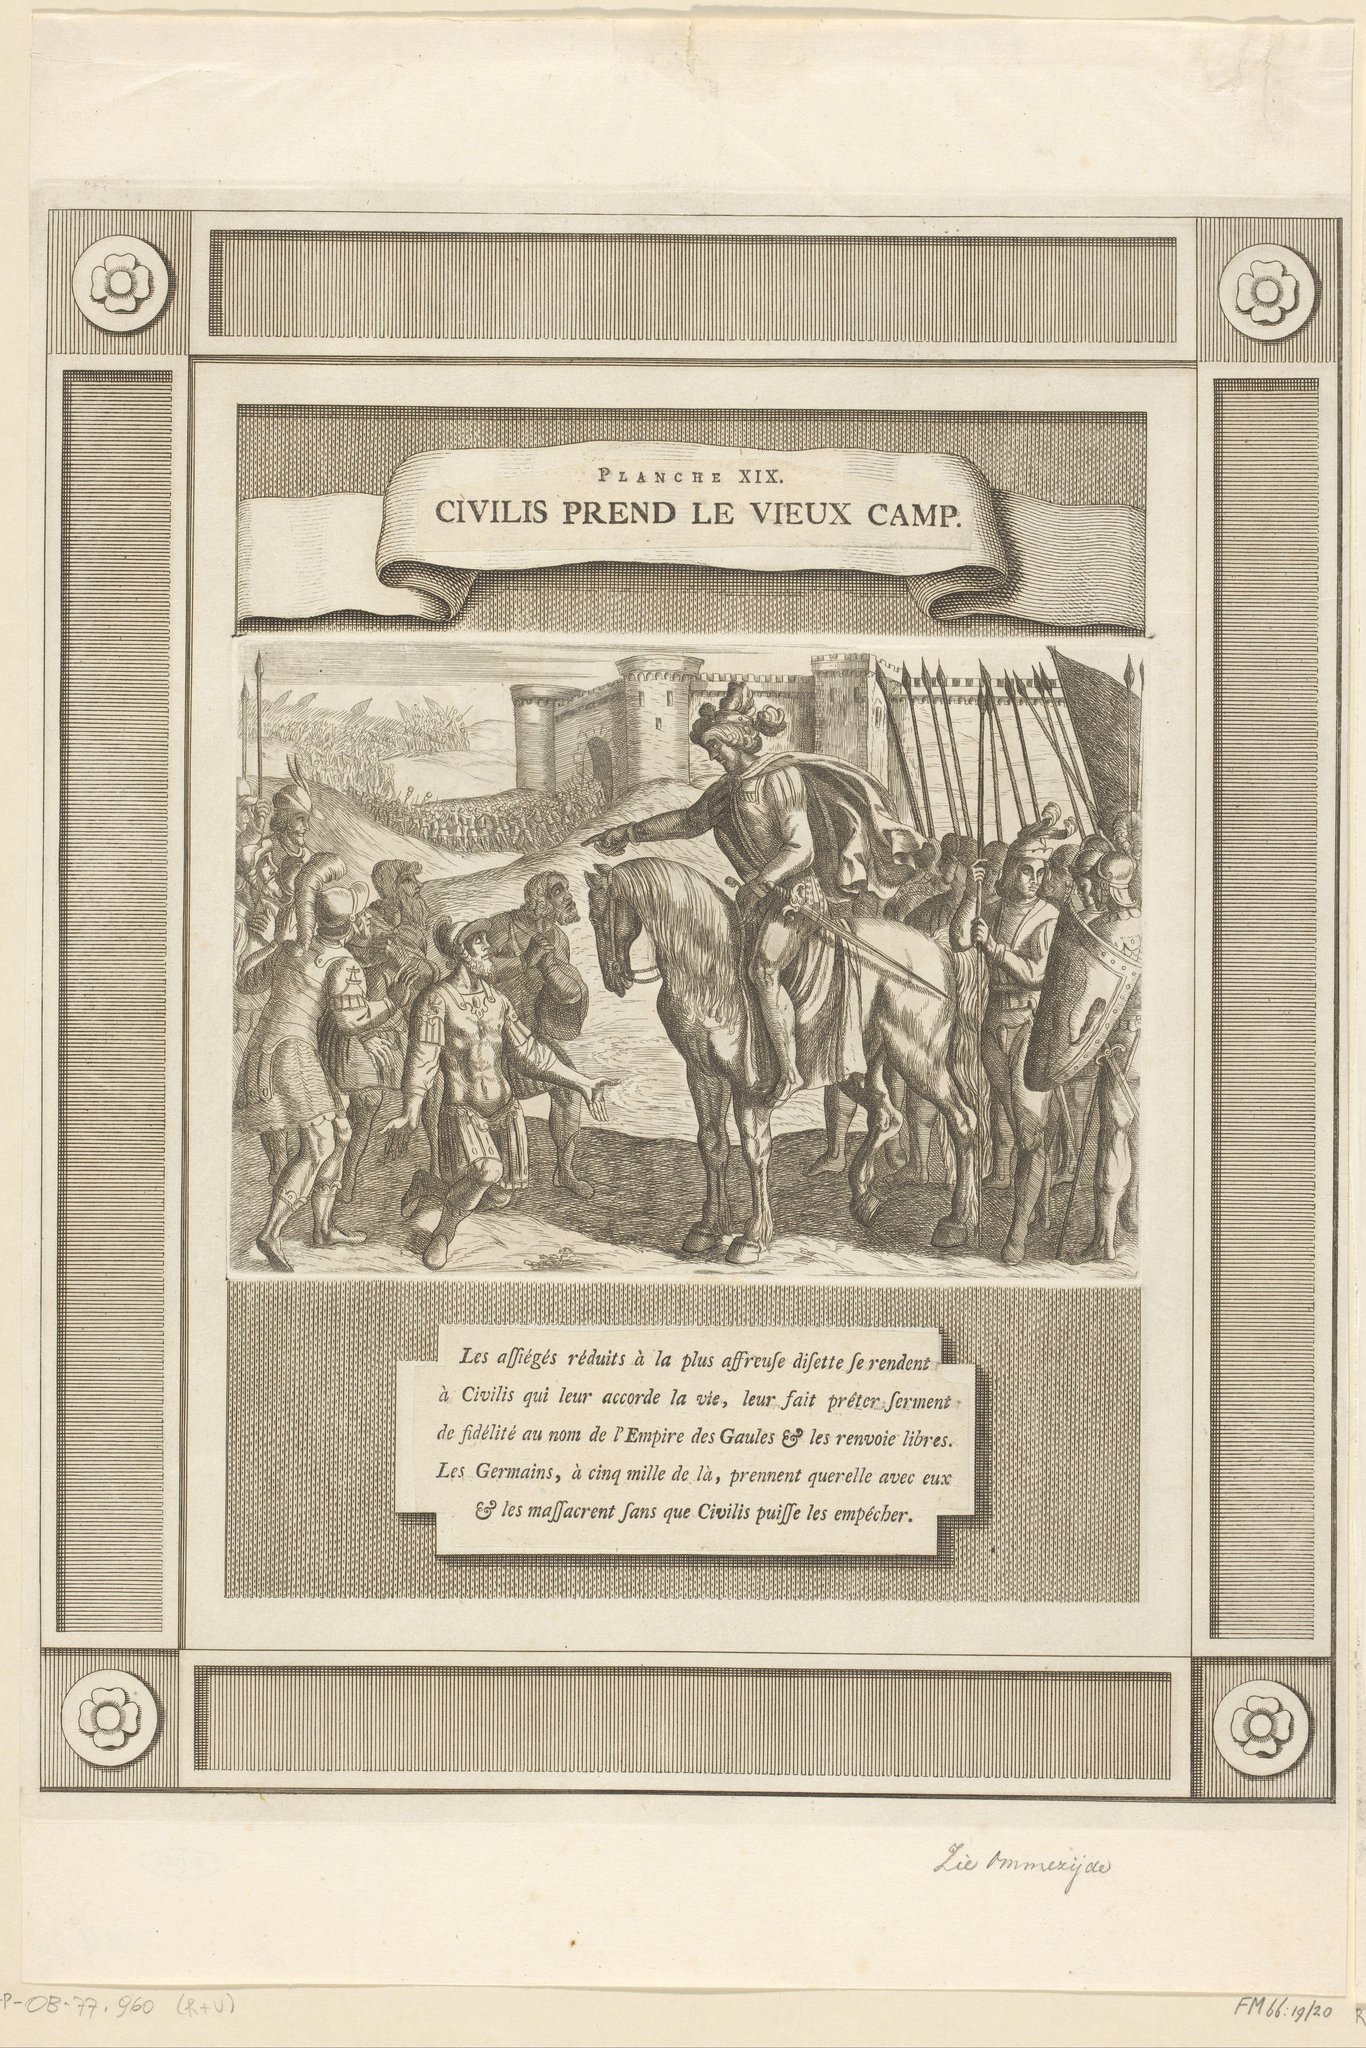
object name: history print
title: Civilis prend le vieux camp / planche XIX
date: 1768-1770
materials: paper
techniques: engraving, etching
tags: battle, fighting in general, extinct, 'historical' peoples (with name), netherlands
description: Uitgeputte Romeinse soldaten smeken Civilis om genade. Civilis gezeten op een paar schenkt hun genade mits zij in een eed trouw zweren aan Nederland. Prent 19 in een serie over de Bataafse Opstand, gekopieerd naar de reeks Batavorum cum Romanis bellum van Antonio Tempesta (Otto Vaenius, Antwerpen 1612). Illustratie voor: Marquis de St. Simon, Histoire de la guerre des Bataves et des Romains, d'après César; Corneille Tacite, Aux dépens de Marc-Michel Rey, Amsterdam 1770. Voorstellingen gedrukt in een grote ornamentele omlijsting waarin bovenaan een uitgeknipte titel en onderaan een onderschrift in het Frans is geplakt.